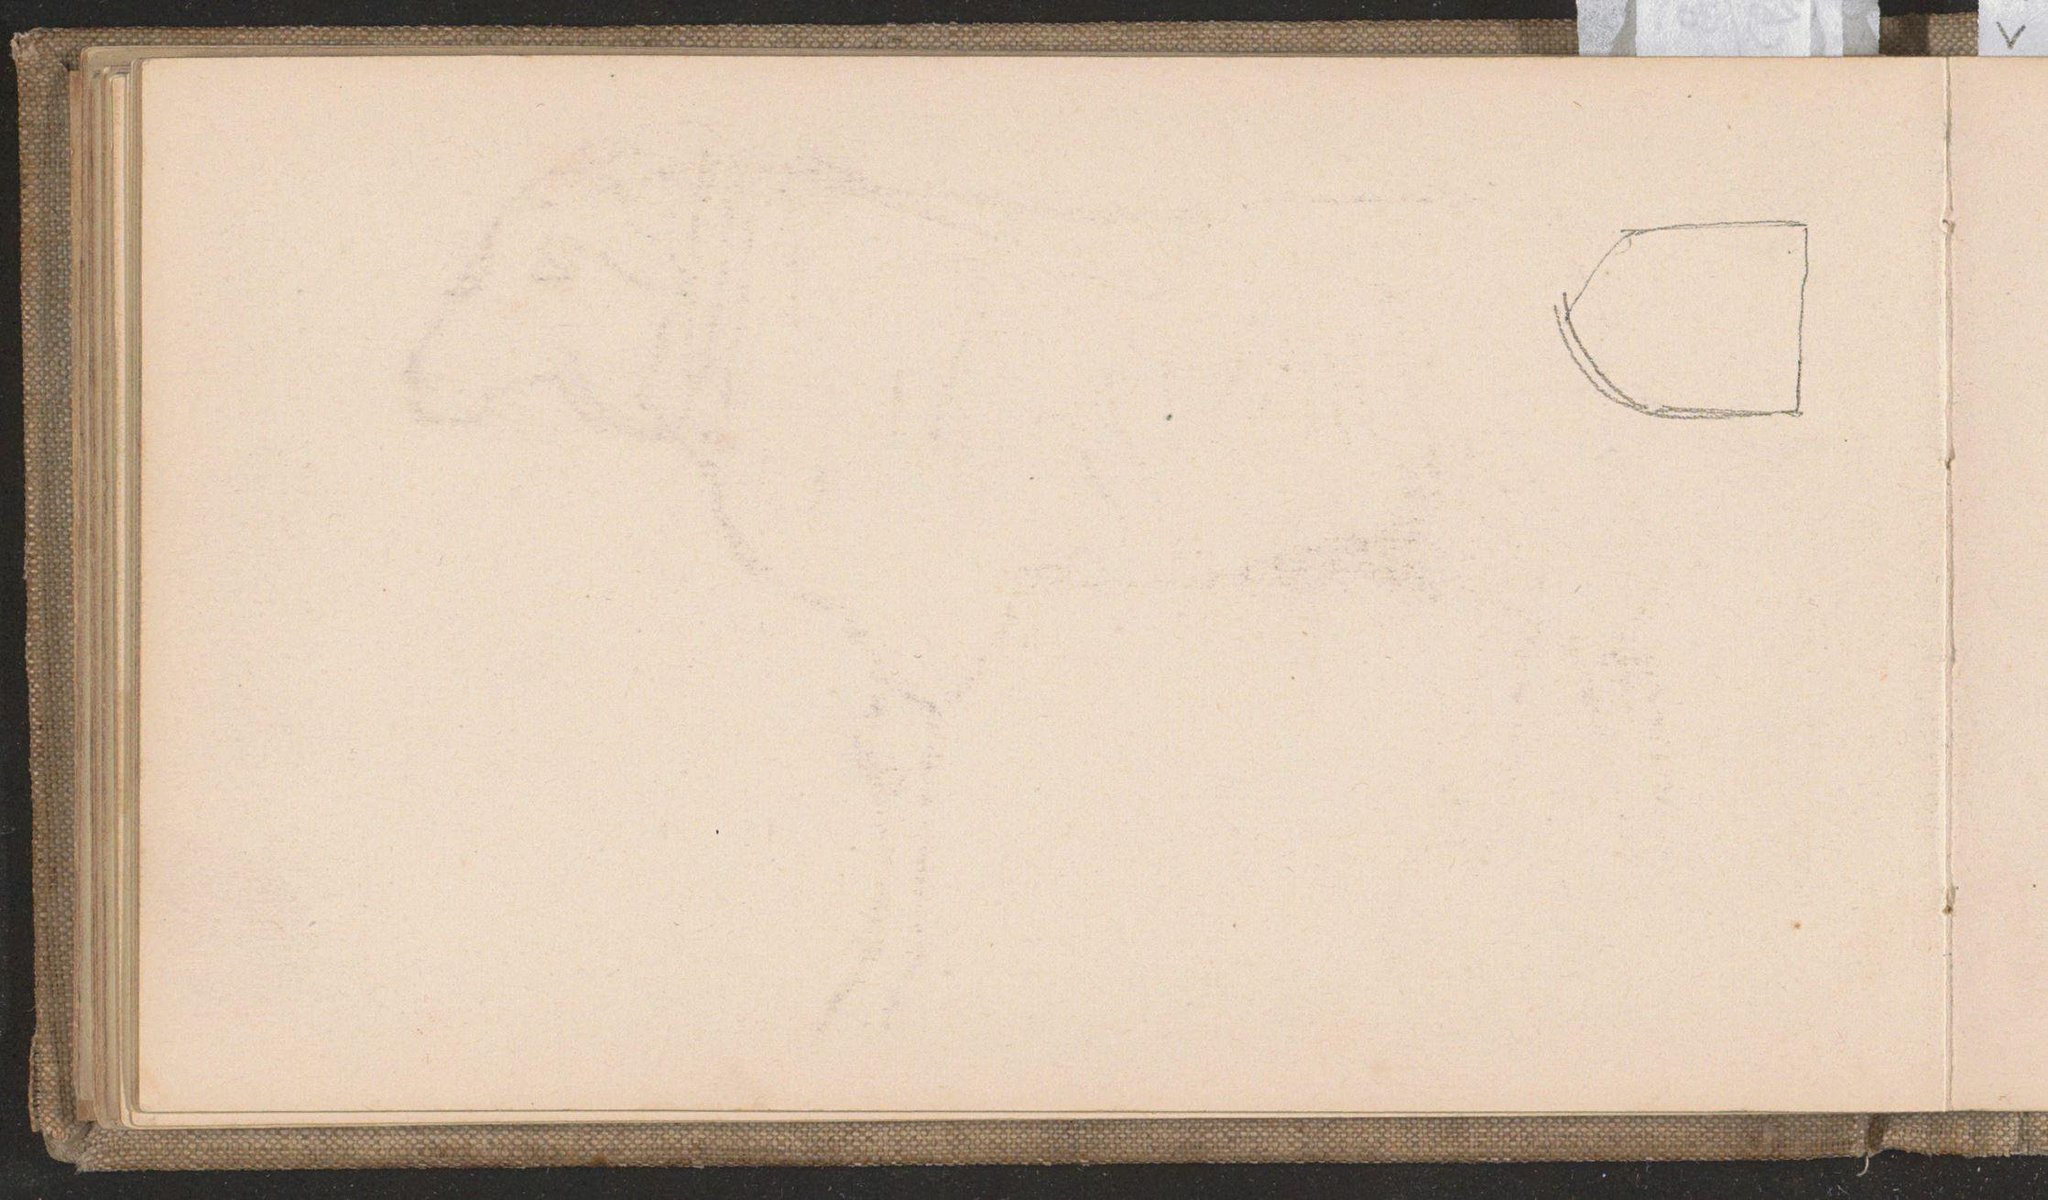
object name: sketchbook leaf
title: Spitsboogvenster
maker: antoon derkinderen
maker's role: draughtsman, painter, print maker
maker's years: 1859-1925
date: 1892-1901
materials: paper, pencil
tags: window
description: Blad 31 verso uit een schetsboek met 51 bladen.